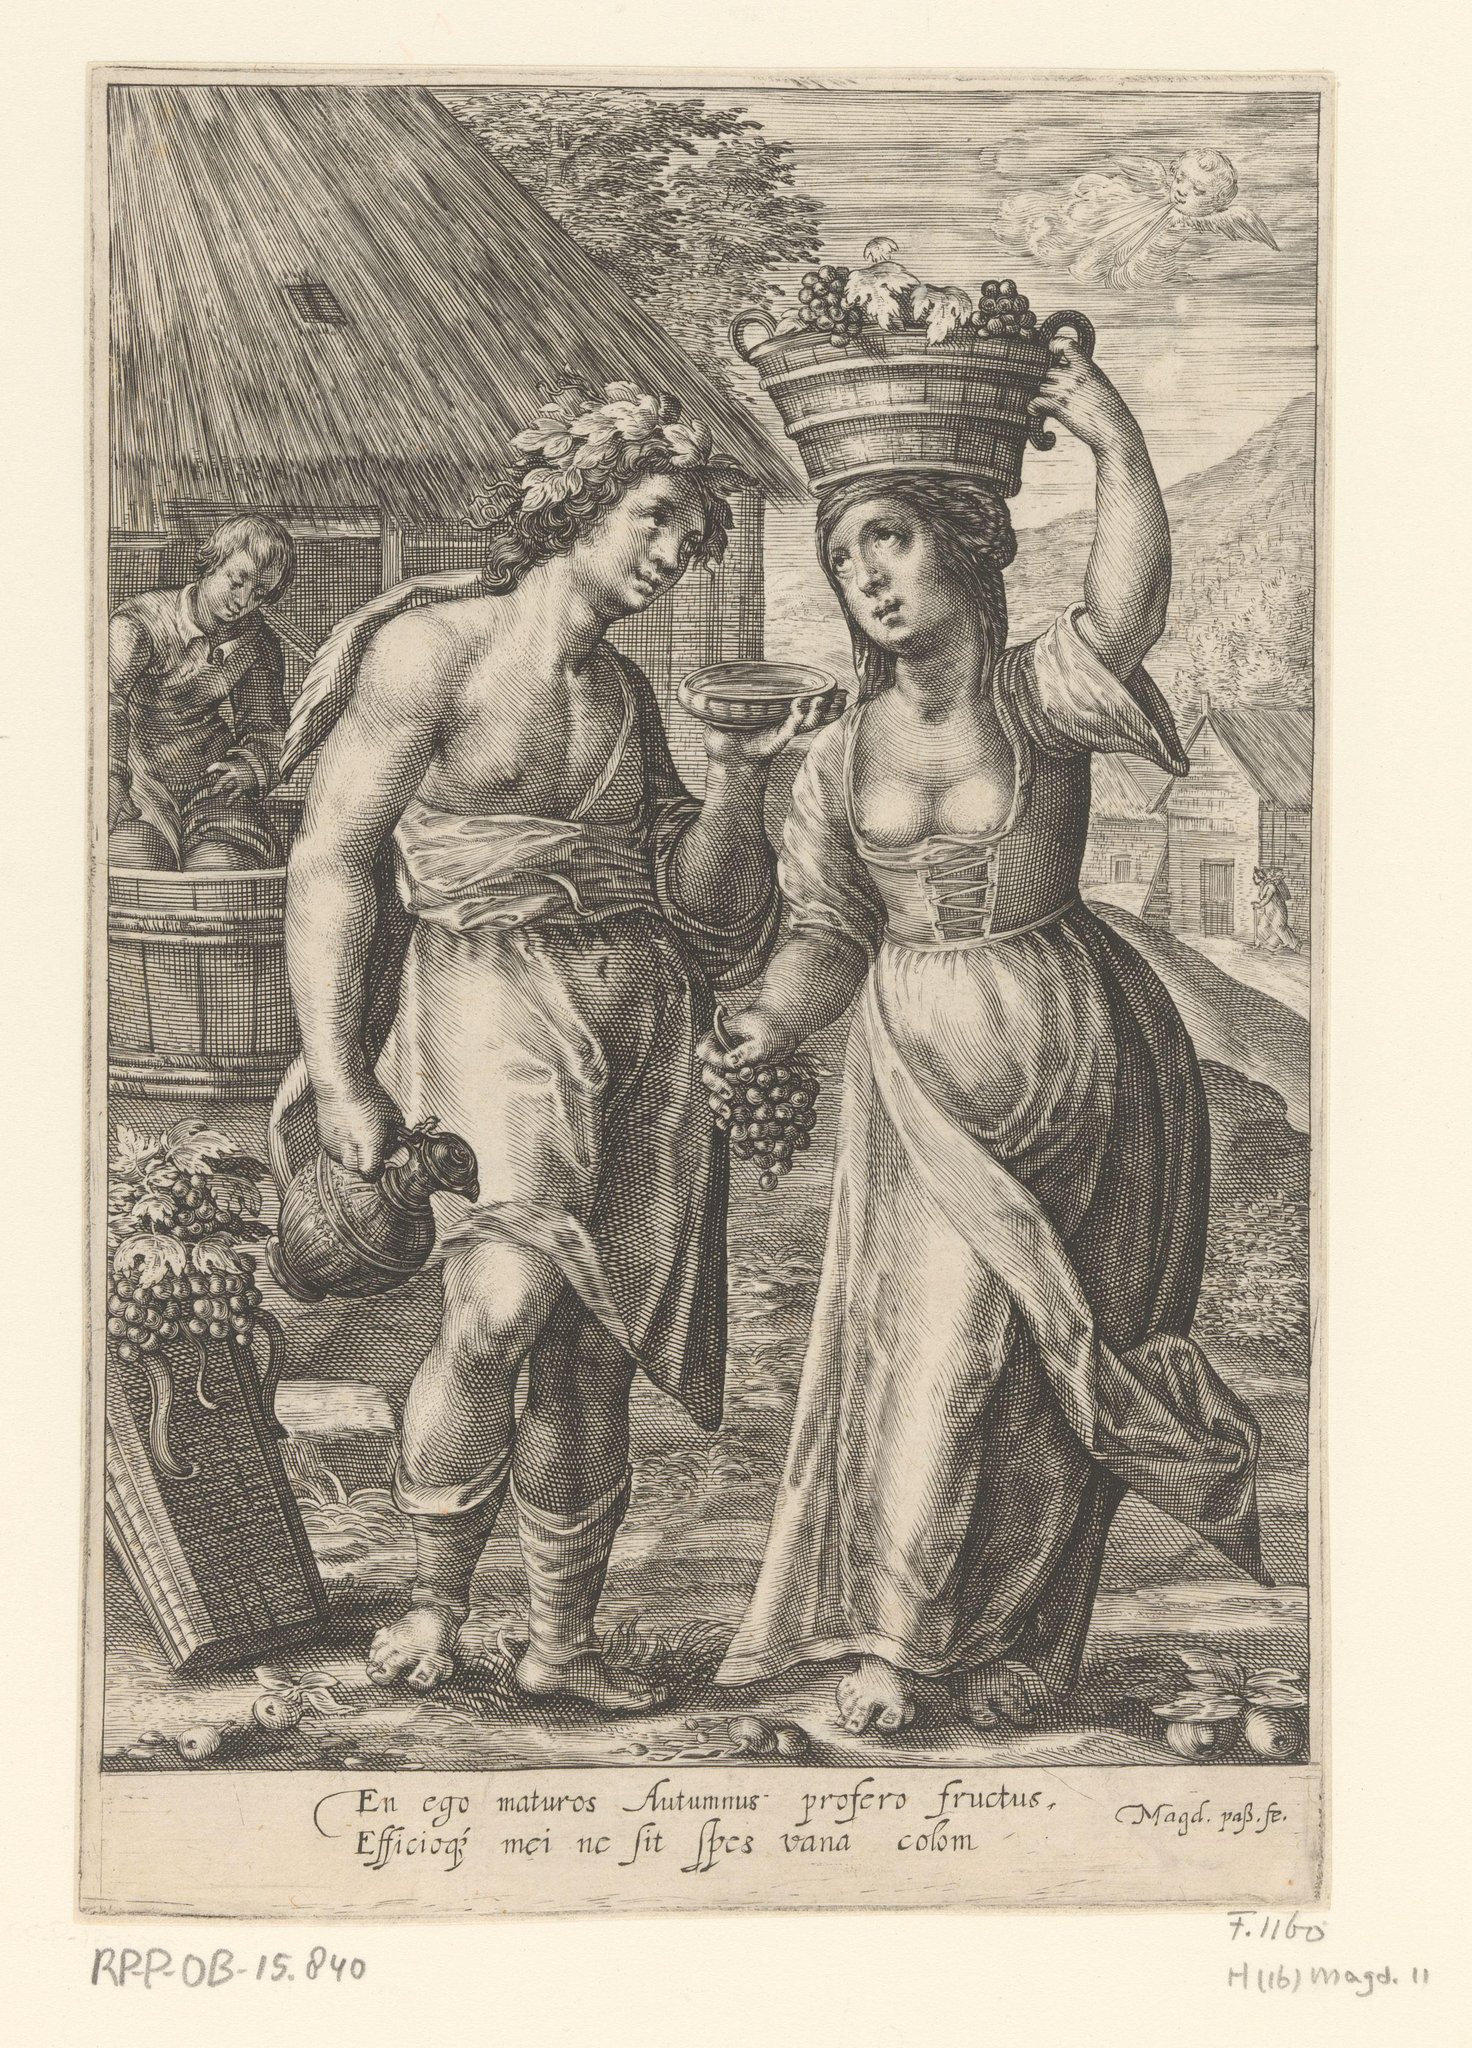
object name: print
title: Herfst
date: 1617-1634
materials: paper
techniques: engraving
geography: utrecht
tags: autumn, fall, 'autumnus'; 'autunno' (ripa) (+ ways of representing seasons and months), pressing grapes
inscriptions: collector's mark: Lugt 240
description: Landschap met een paar tijdens de druivenoogst. De vrouw draagt een mand met druiven op haar hoofd en de man houdt een schaal en een kruik vast. Op de achtergrond een jongeman die druiven perst. In de marge een tweeregelig onderschrift in het Latijn.